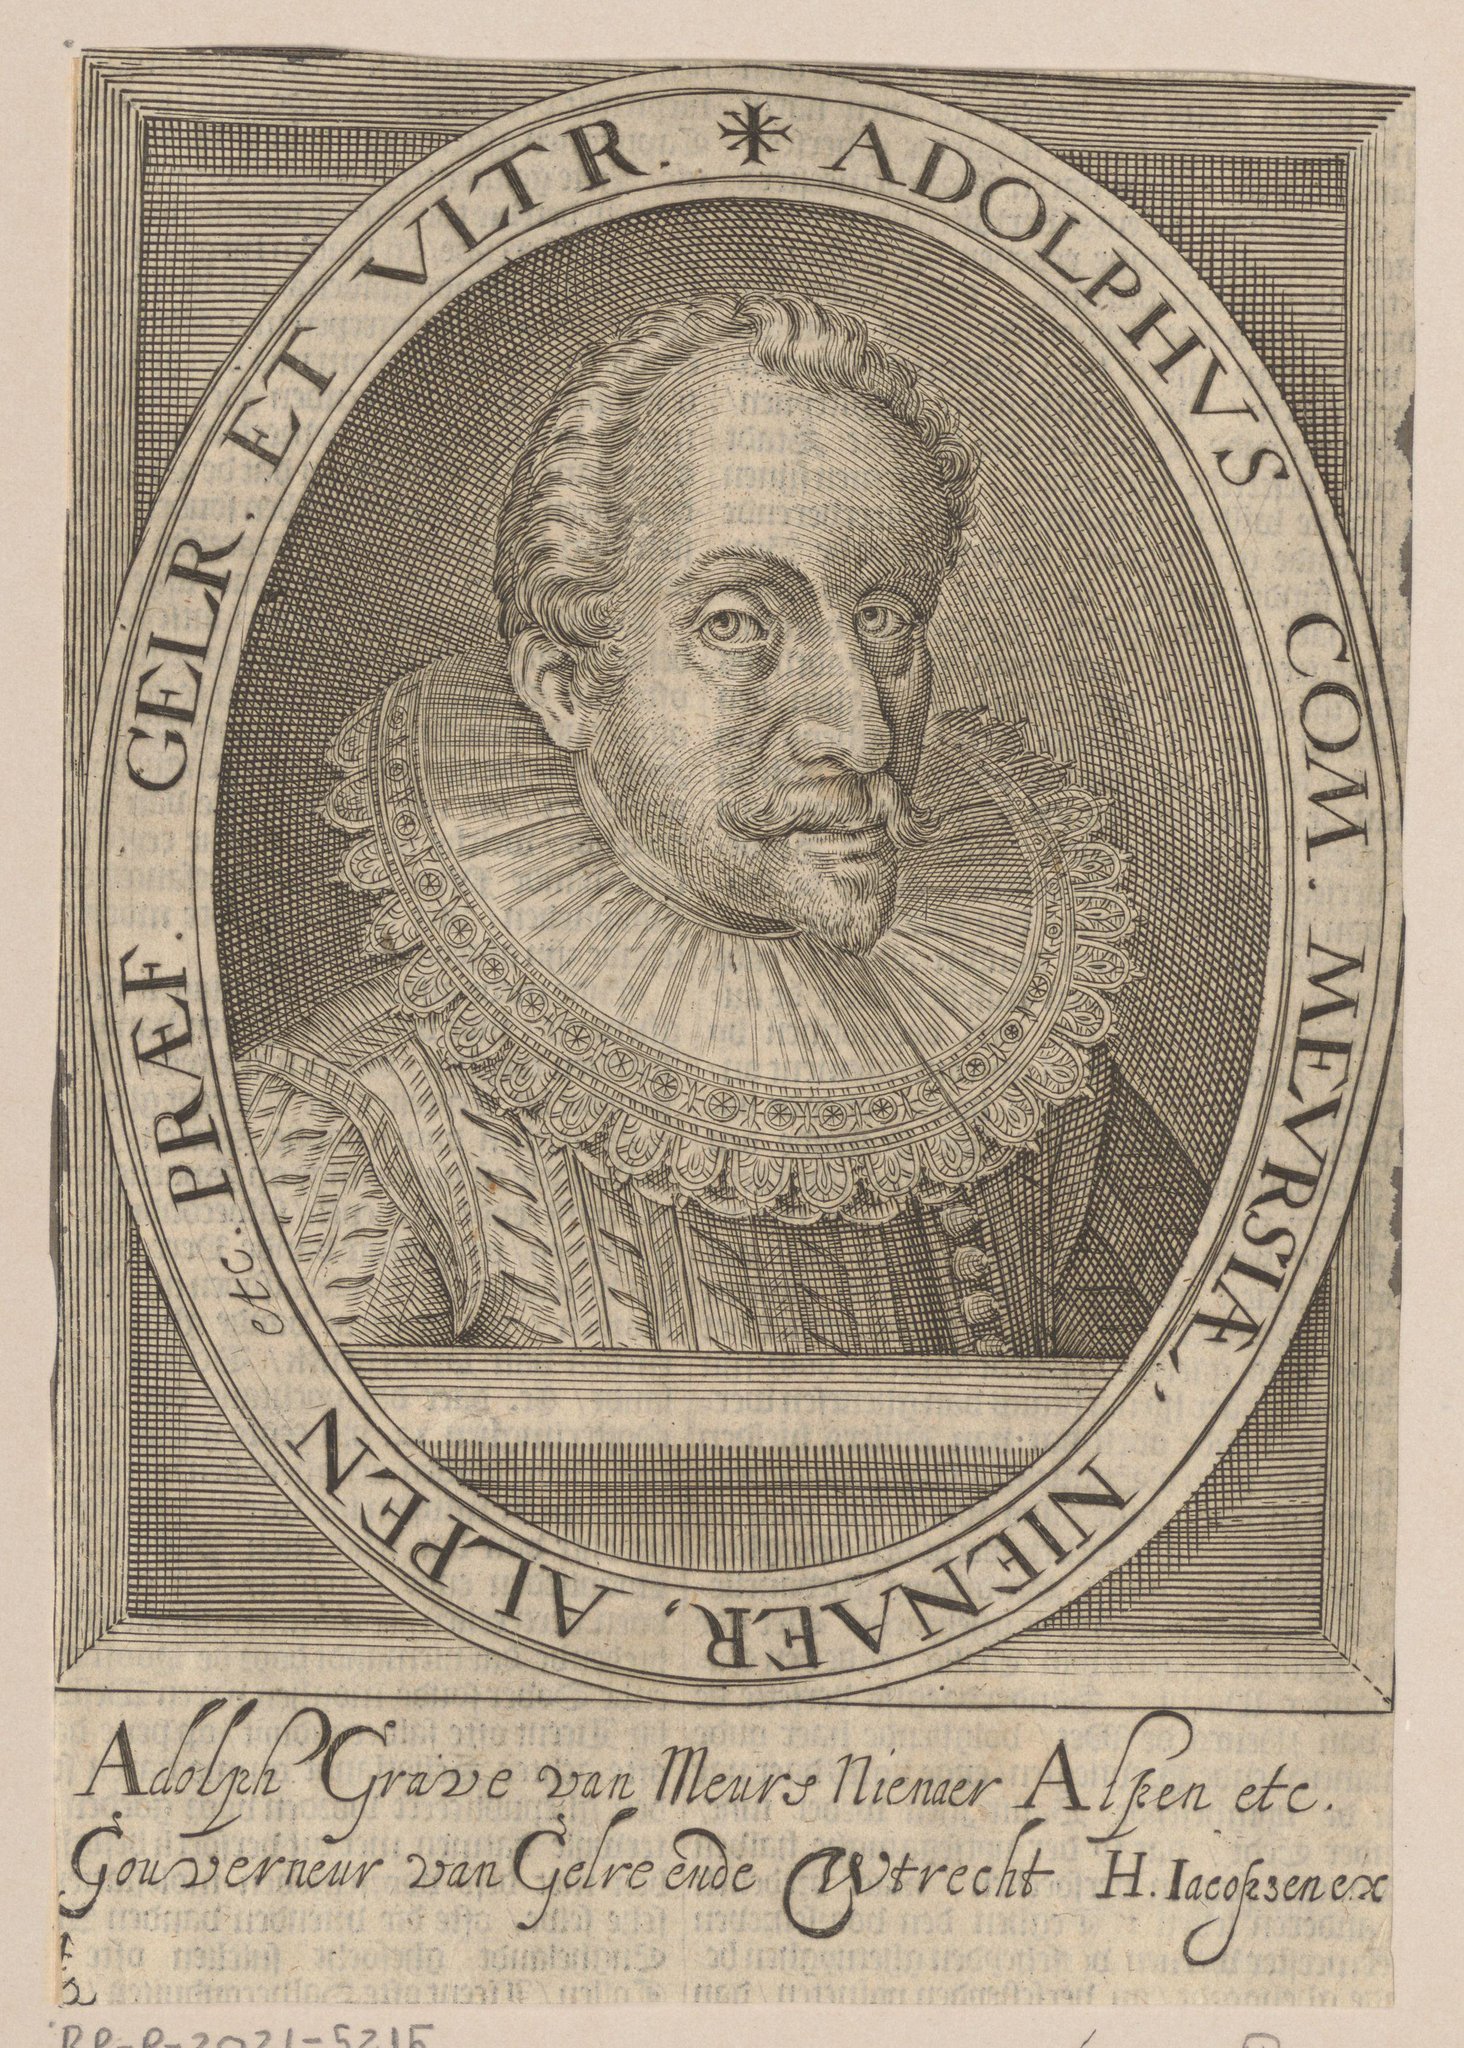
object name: print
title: Portret van Adolf, graaf van Nieuwenaar en Meurs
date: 1623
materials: paper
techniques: engraving, letterpress printing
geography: the hague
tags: arnhem, commander-in-chief, general, marshal, historical persons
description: Prent uit: Meteren, Emanuel van. Historie der Neder-landscher ende haerder na-buren oorlogen ende geschiedenissen (...). Den Haag: weduwe en erfgenamen van Hillebrant Jacobszoon van Wouw, 1623. Prent mogelijk ook gebruikt in eerdere en latere edities.